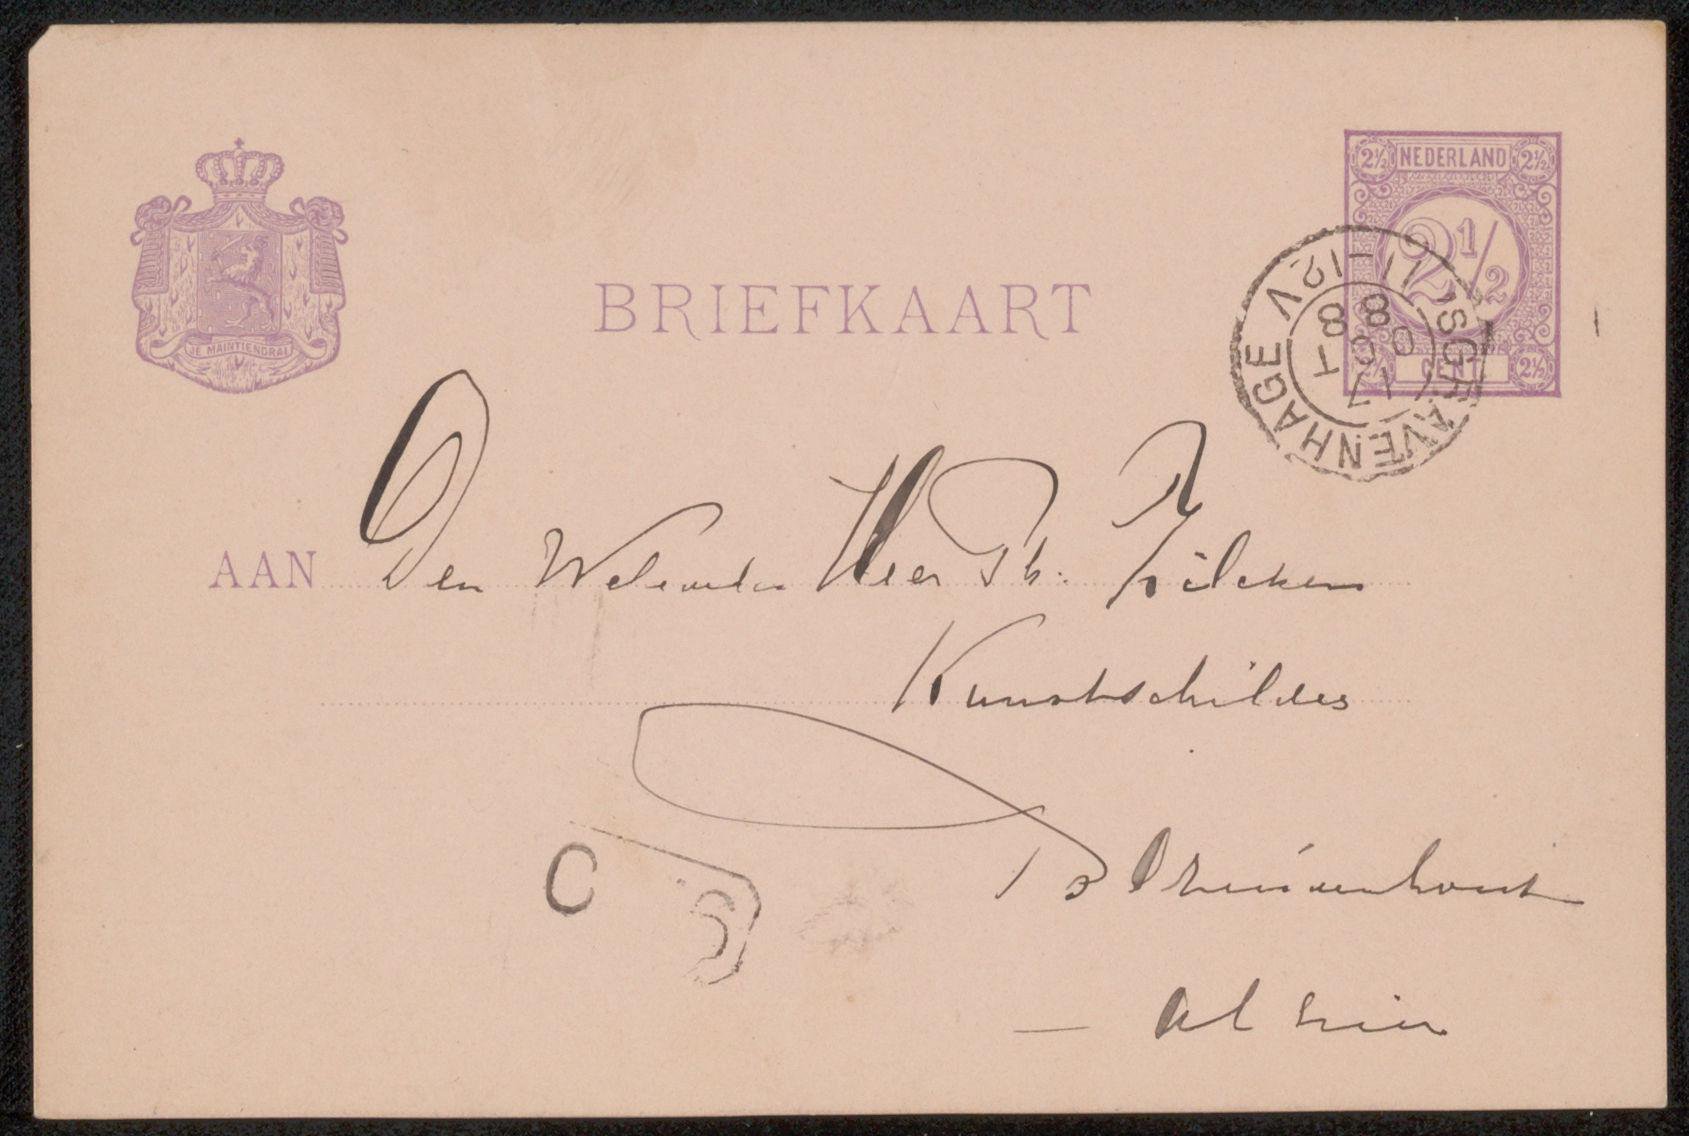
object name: postcard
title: Briefkaart aan Philip Zilcken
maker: suze robertson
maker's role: draughtsman, painter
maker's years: 1855-1922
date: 1888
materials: cardboard, ink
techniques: pen, writing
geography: the hague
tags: print maker, pieter de josselin de jong, philip zilcken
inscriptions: collector's mark: ‘RPK’